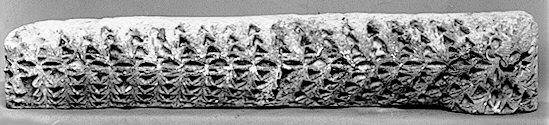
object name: fragment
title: Fragment from a Molding with Vines and an Amphora (Vase)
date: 501-600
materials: limestone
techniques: carving, relief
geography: egypt